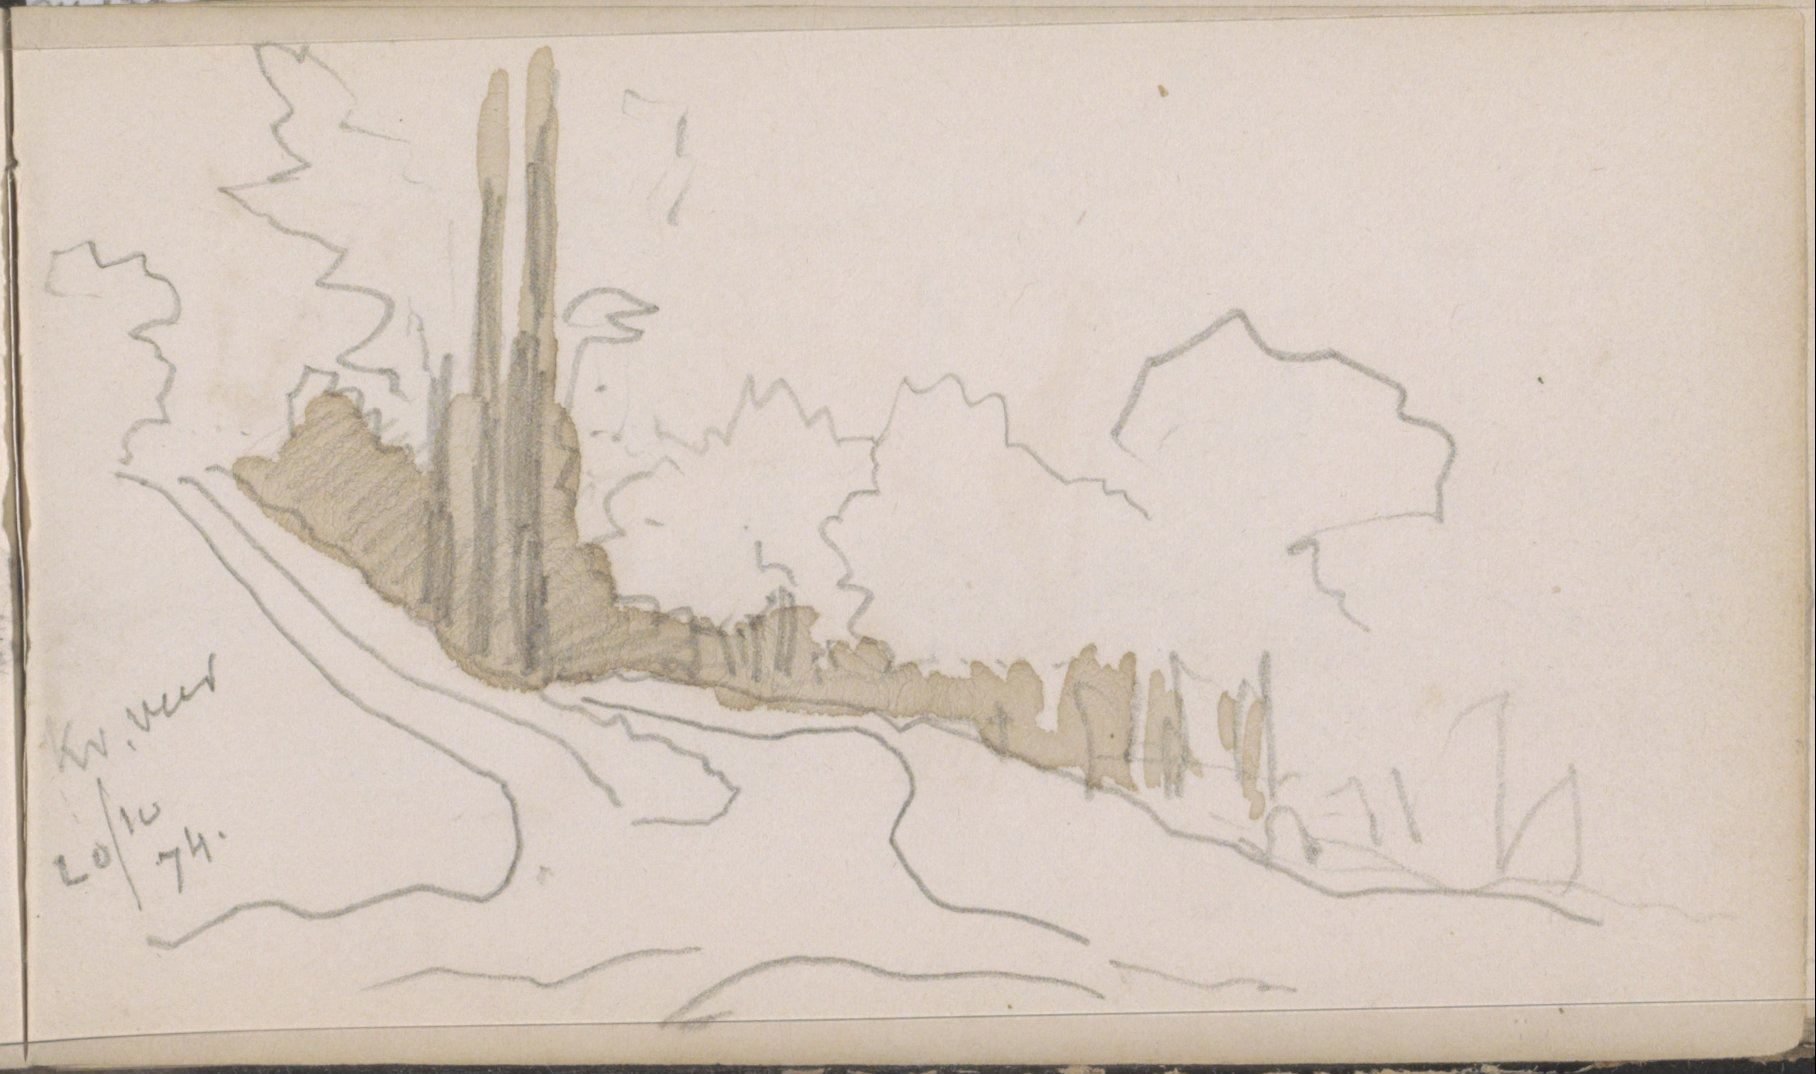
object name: sketchbook leaf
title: Koeien bij de Bergweg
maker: johannes tavenraat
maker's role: draughtsman, painter, print maker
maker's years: 1809-1881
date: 1810-1874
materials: ink, paper, pencil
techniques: pen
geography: rotterdam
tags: cow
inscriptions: date and inscription: ‘zonnig/ Bergweg 10. oct.74’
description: Blad 32 recto uit een schetsboek met 46 bladen.